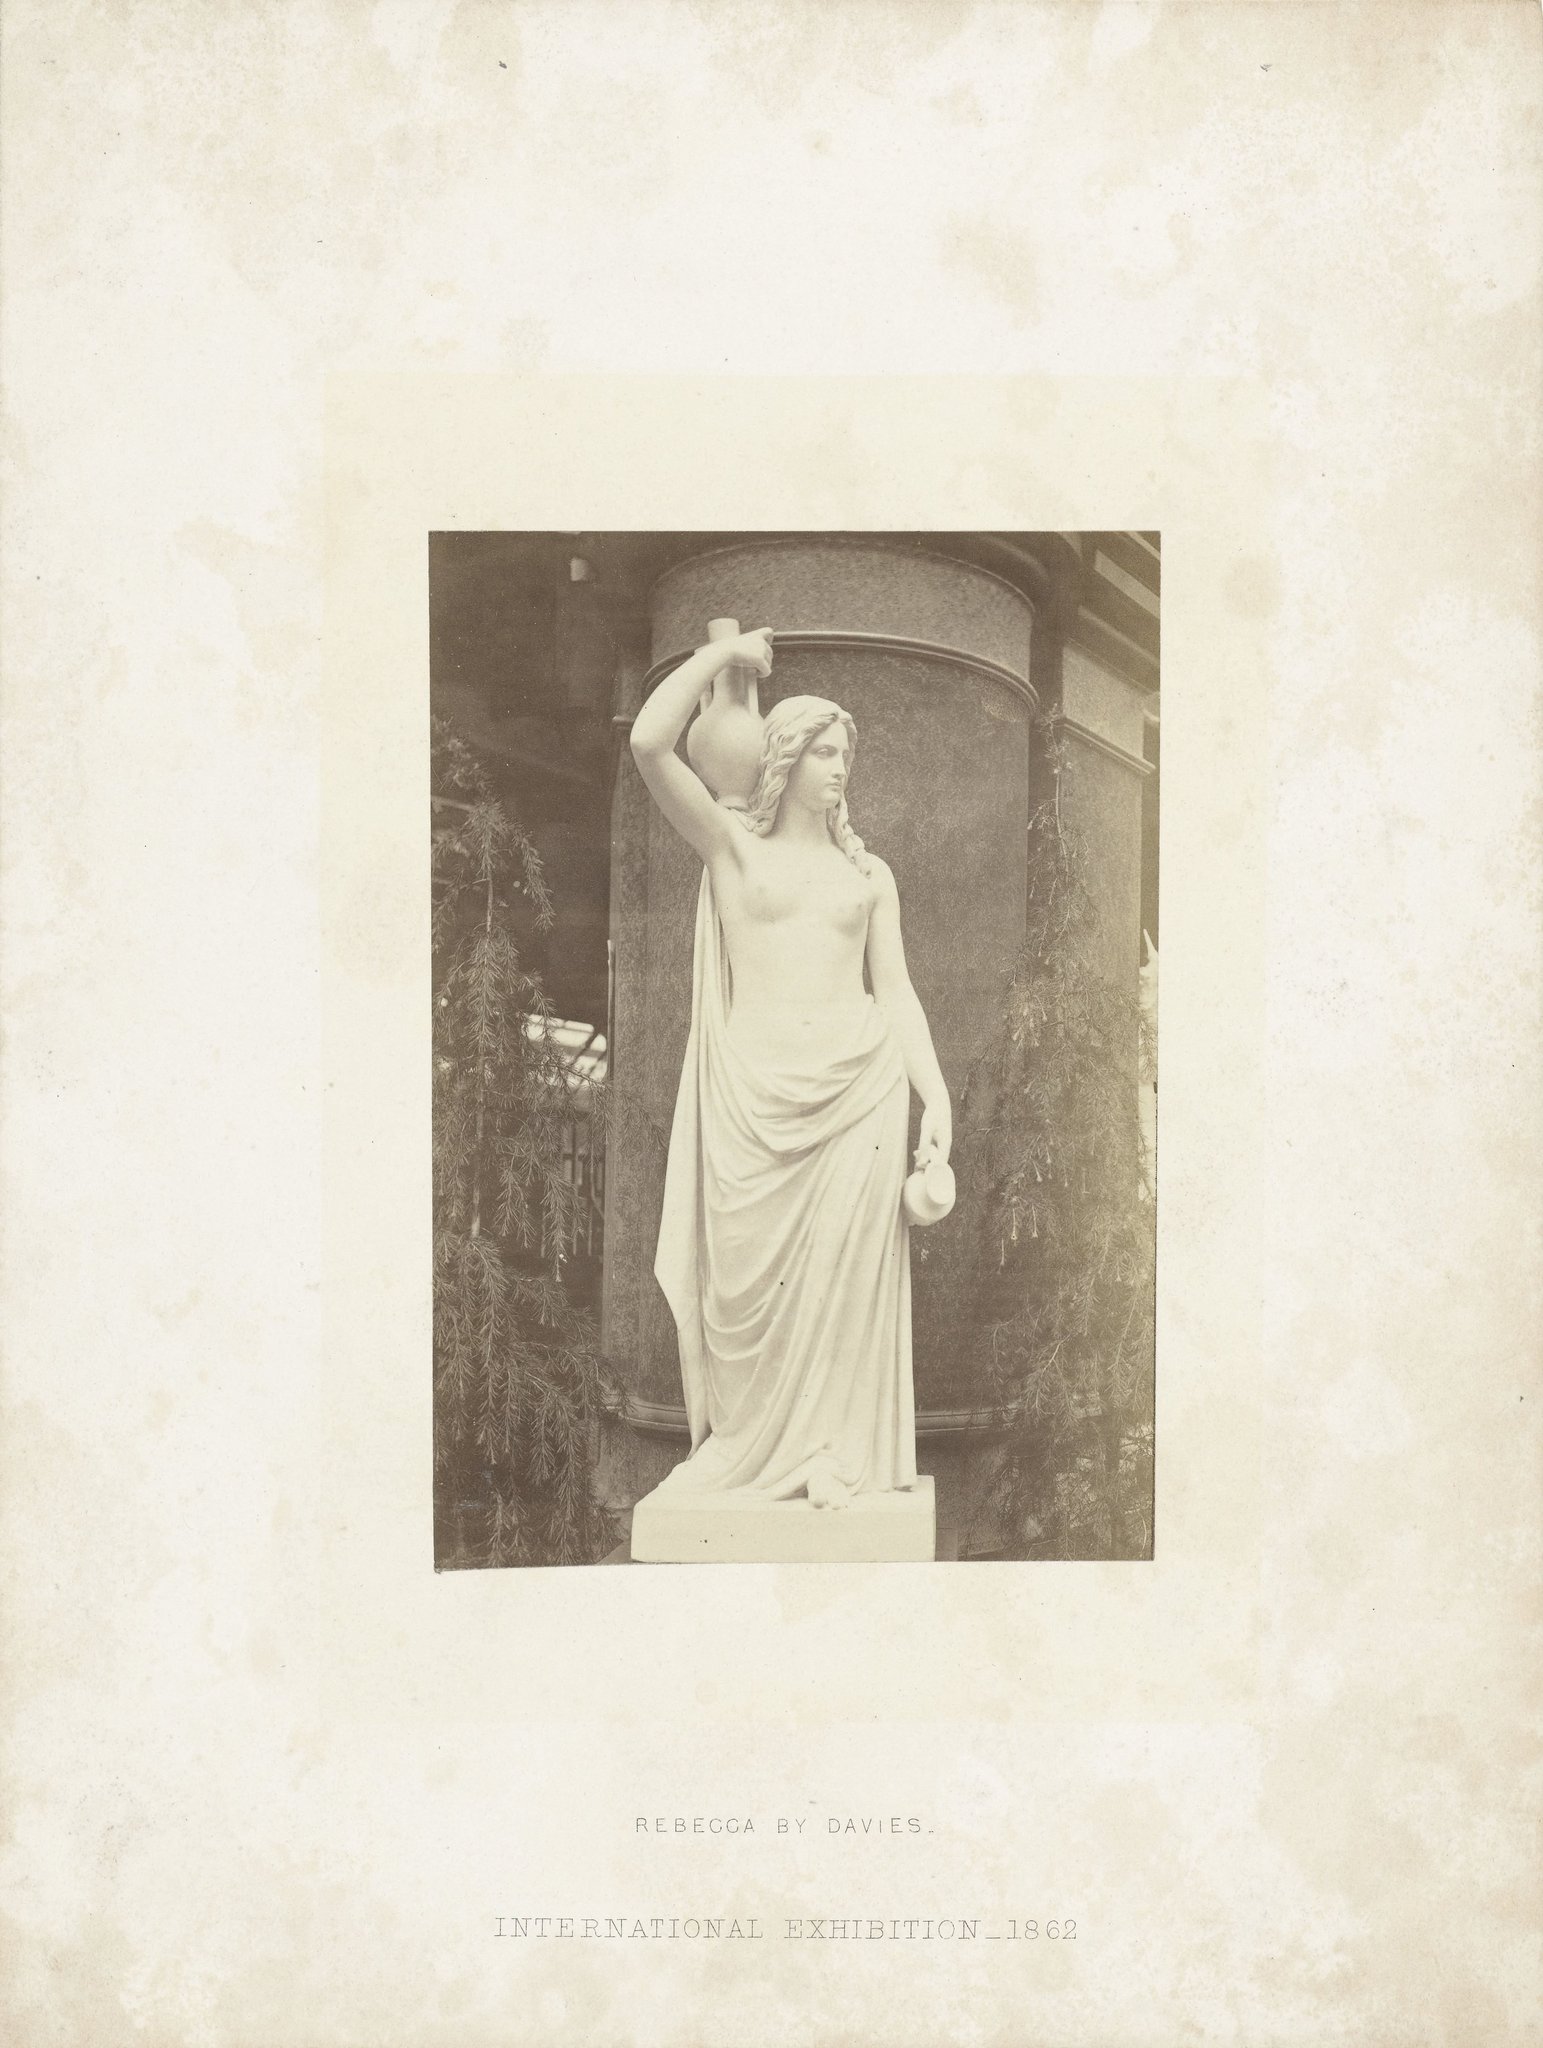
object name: photograph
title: Rebecca by Davies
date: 1862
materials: cardboard, paper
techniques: albumen print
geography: london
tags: sculpture, london